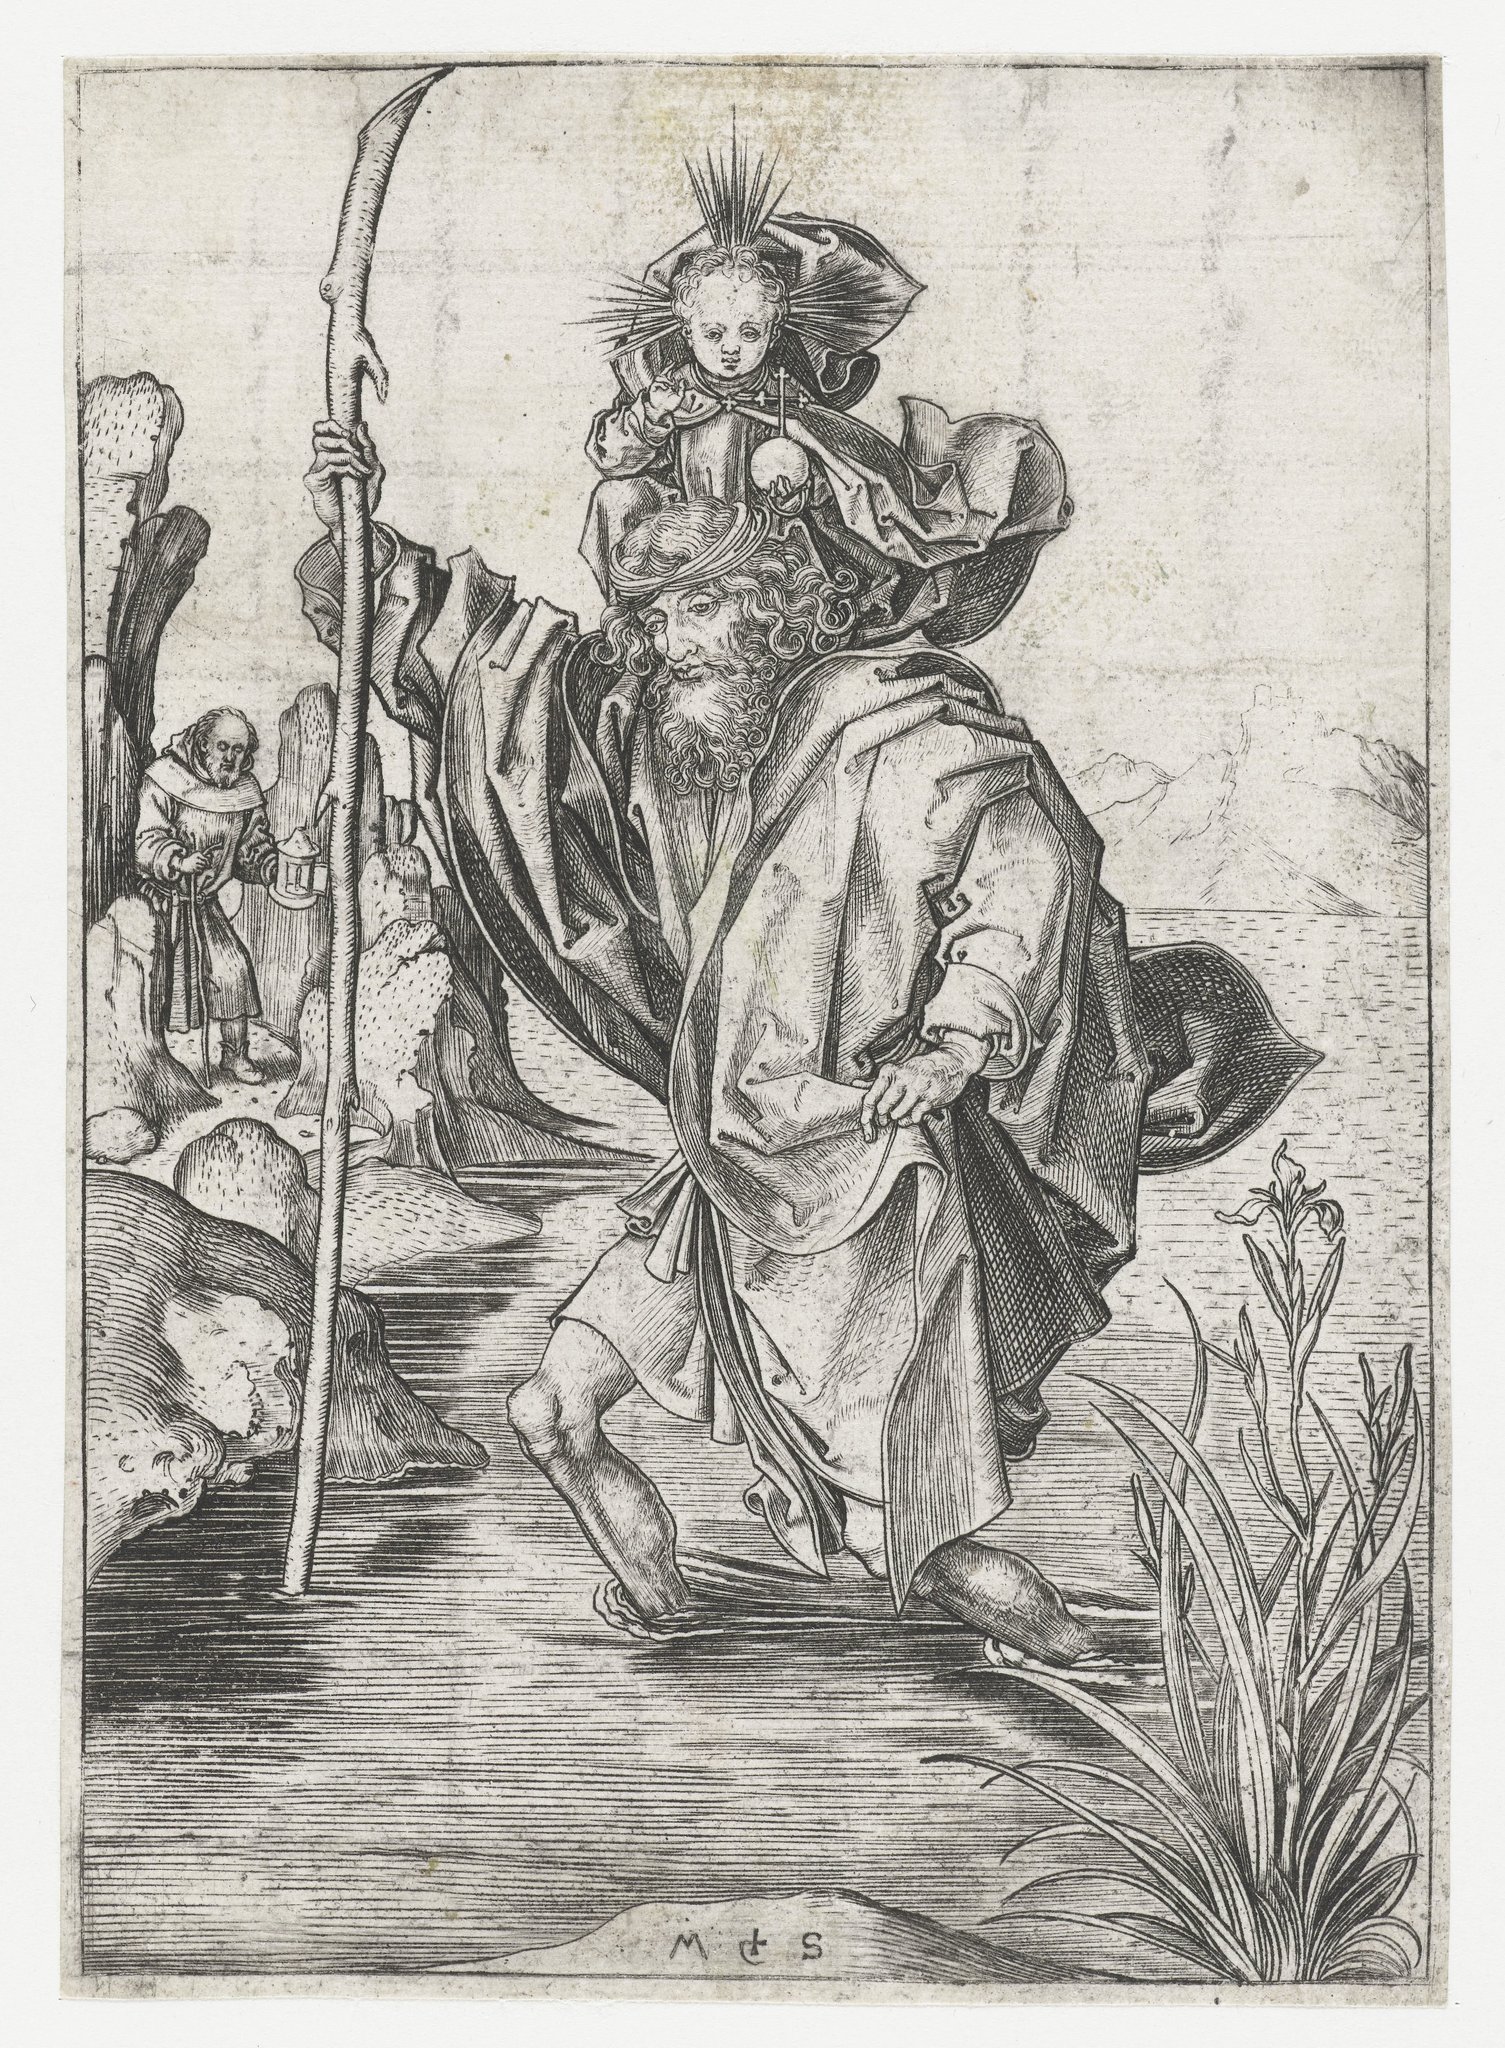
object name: print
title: De Heilige Christoffel draagt het Christuskind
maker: martin schongauer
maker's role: print maker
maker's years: 1430-1491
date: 1470-1491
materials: paper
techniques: engraving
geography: germany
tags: st. christopher, with the infant christ on his shoulders, wading through the water and carrying his staff (palm-tree); sometimes a hermit stands on the further bank beside a chapel, a lantern in his hand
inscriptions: collector's mark: Lugt 240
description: De Heilige Christoffel waadt door een rivier met een stok in zijn rechterhand en het Christuskind op zijn schouders. Aan de oever staat een kluizenaar met een lamp.